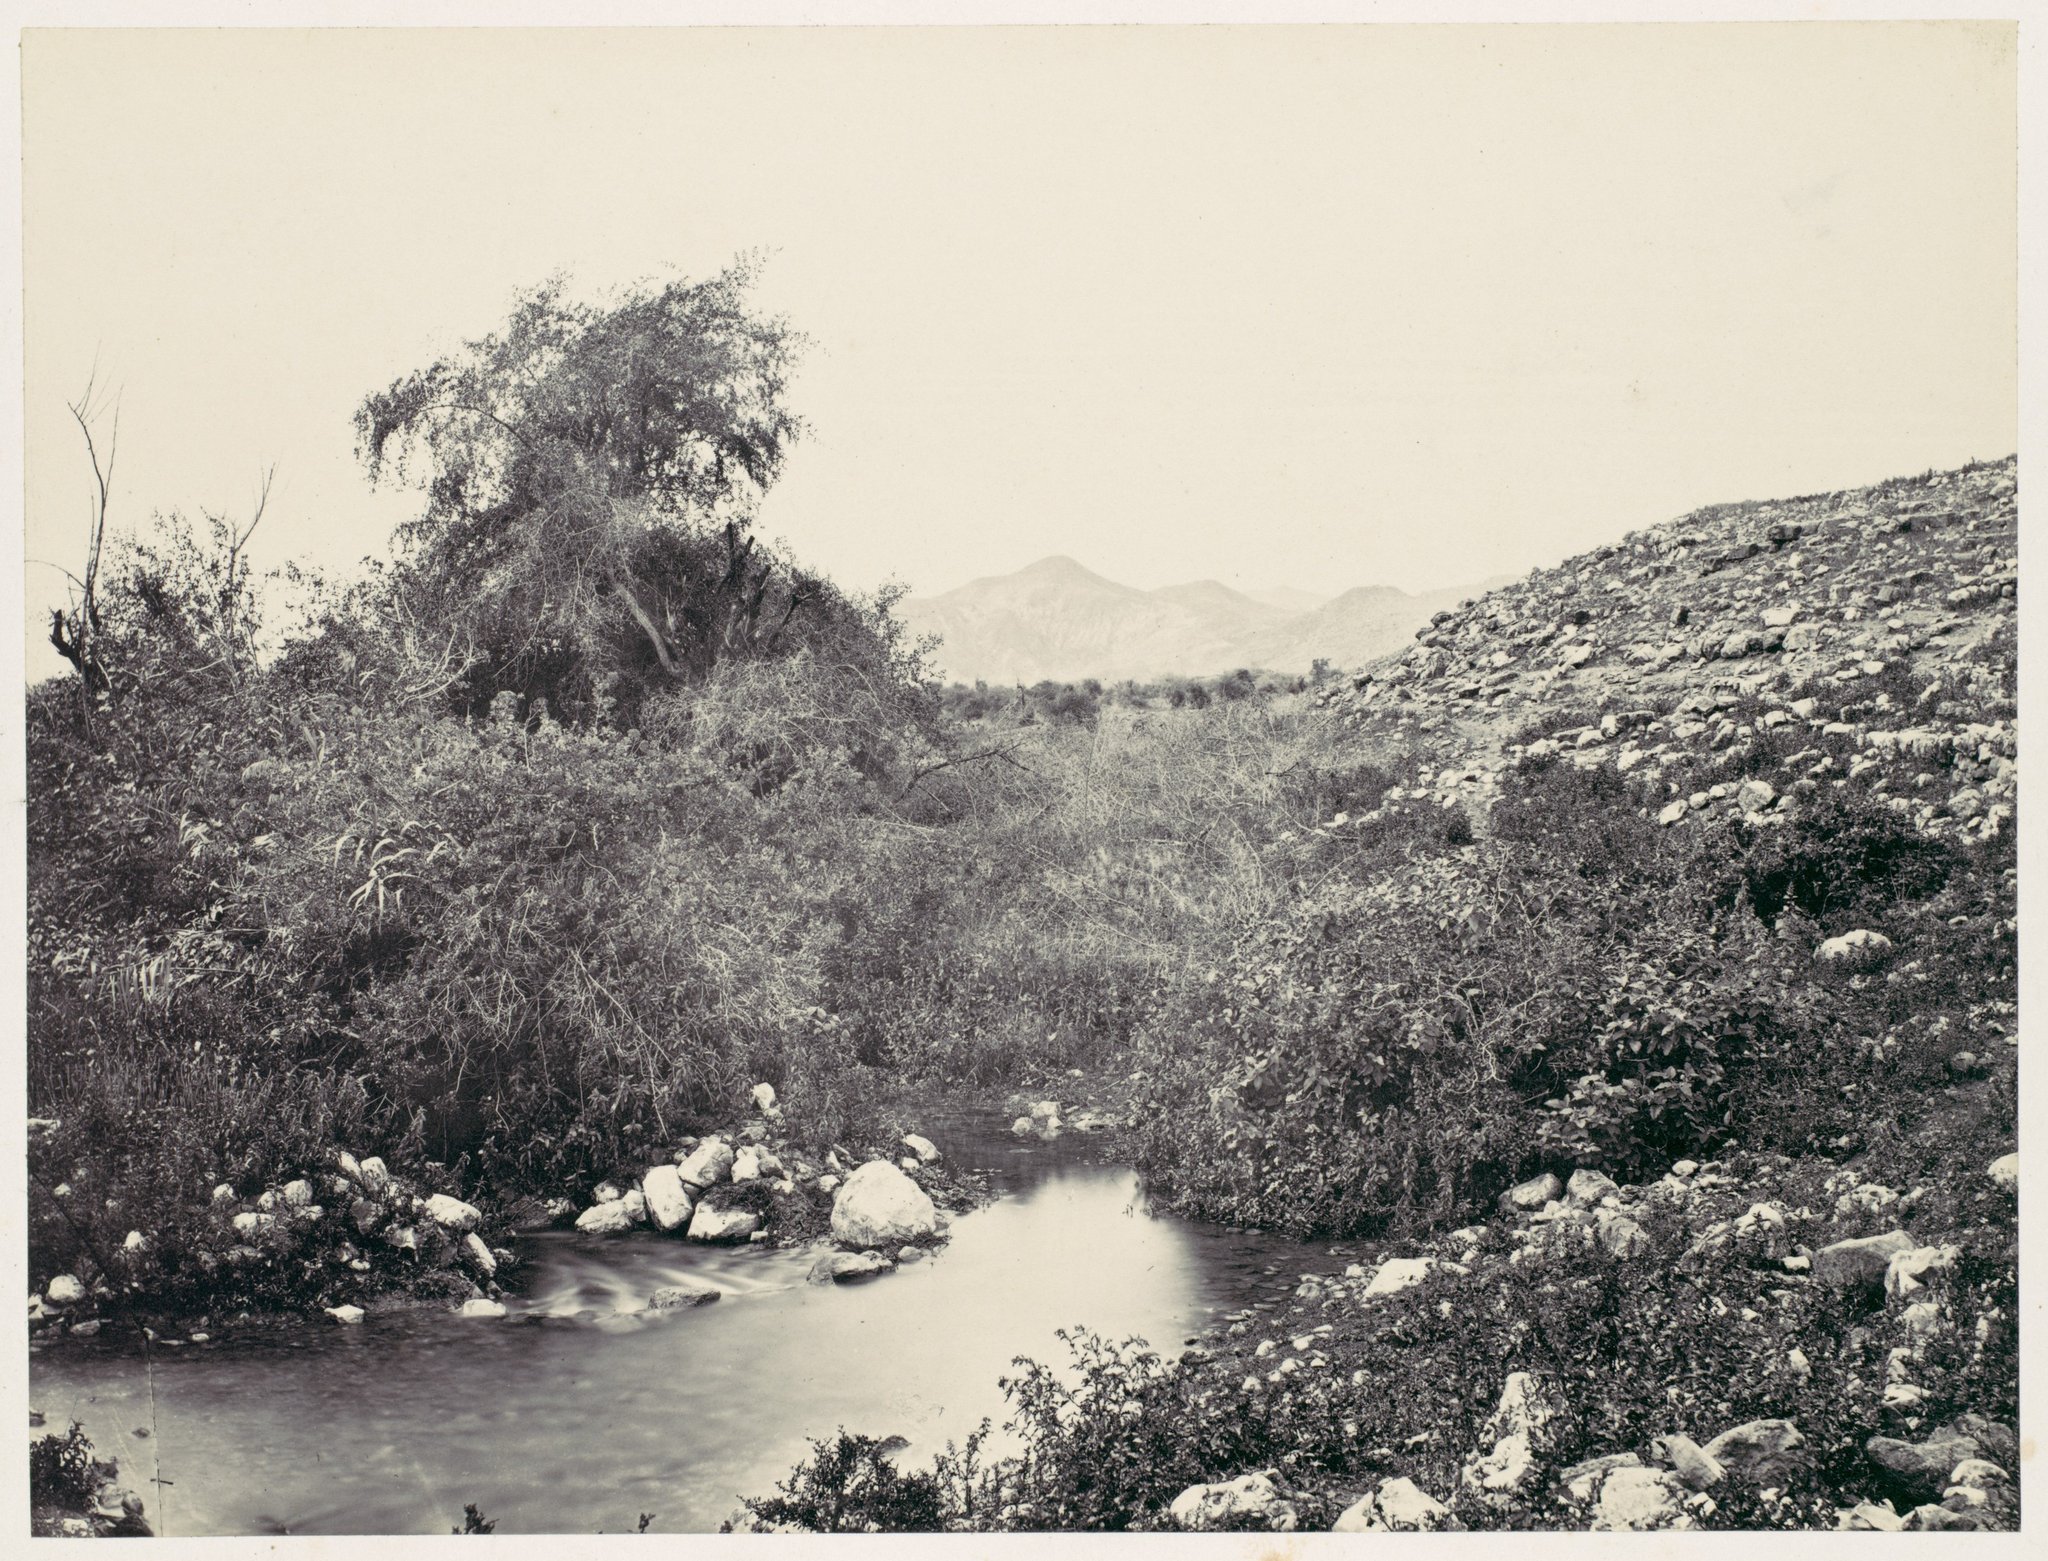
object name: photograph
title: The Fountain of Jerico and Probable Site of the City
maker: francis frith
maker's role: publisher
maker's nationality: english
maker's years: 1822-1898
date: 1857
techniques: albumen silver print, glass negative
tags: landscapes